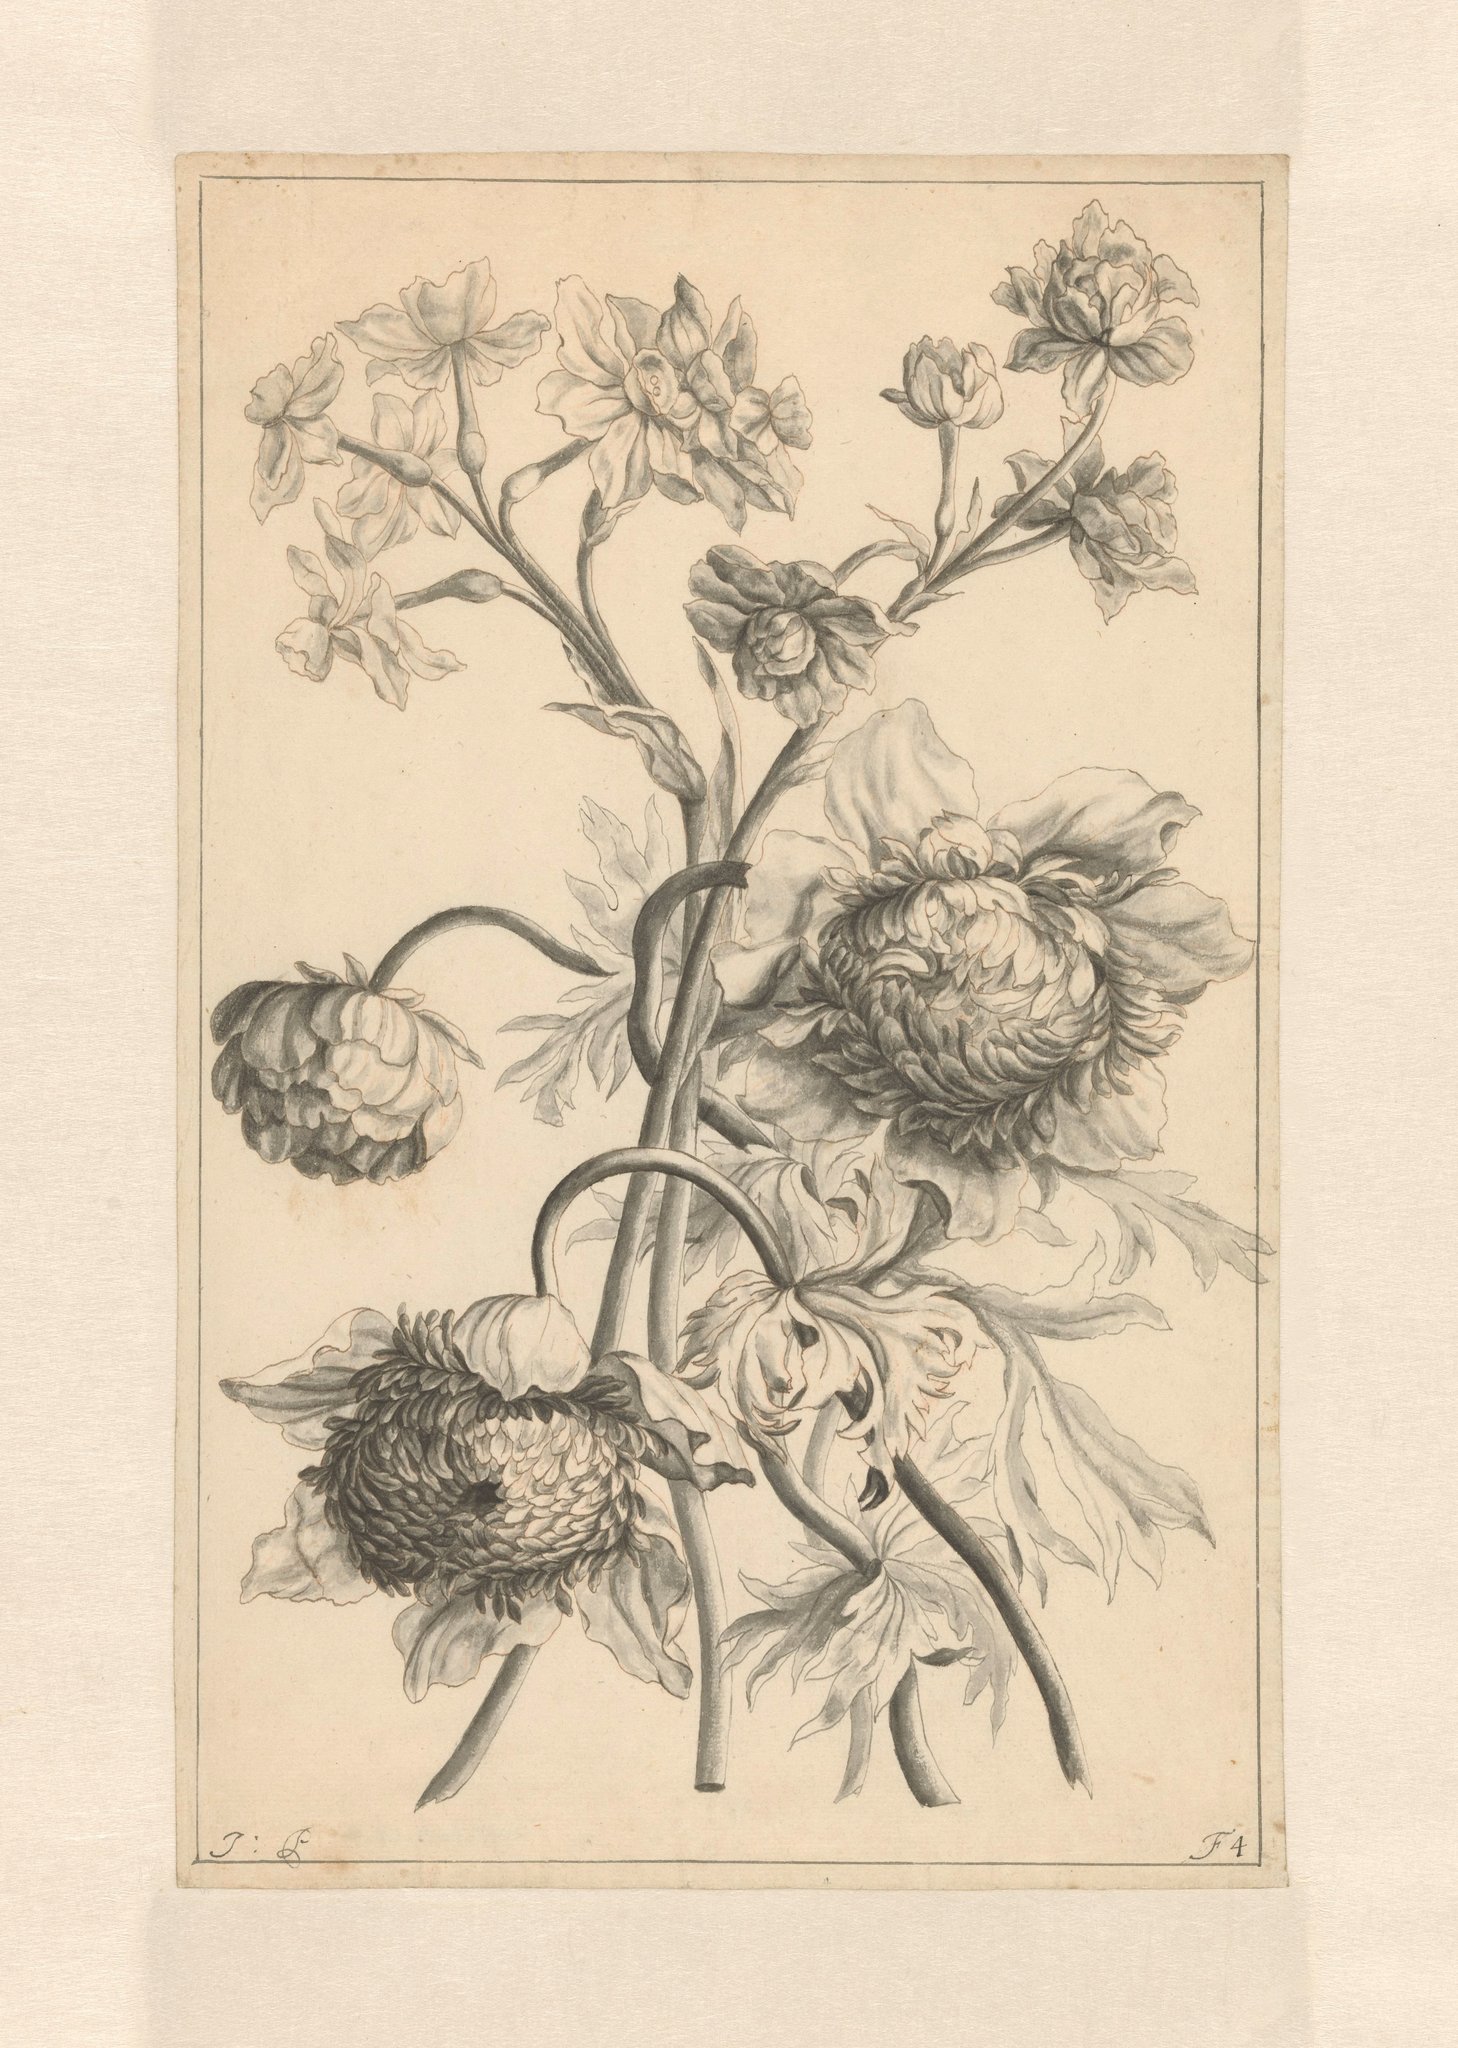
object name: drawing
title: Twee takken met een pioenroos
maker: j. porteret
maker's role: draughtsman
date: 1700-1800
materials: paper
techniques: brush, pen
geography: france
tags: flowers: peony